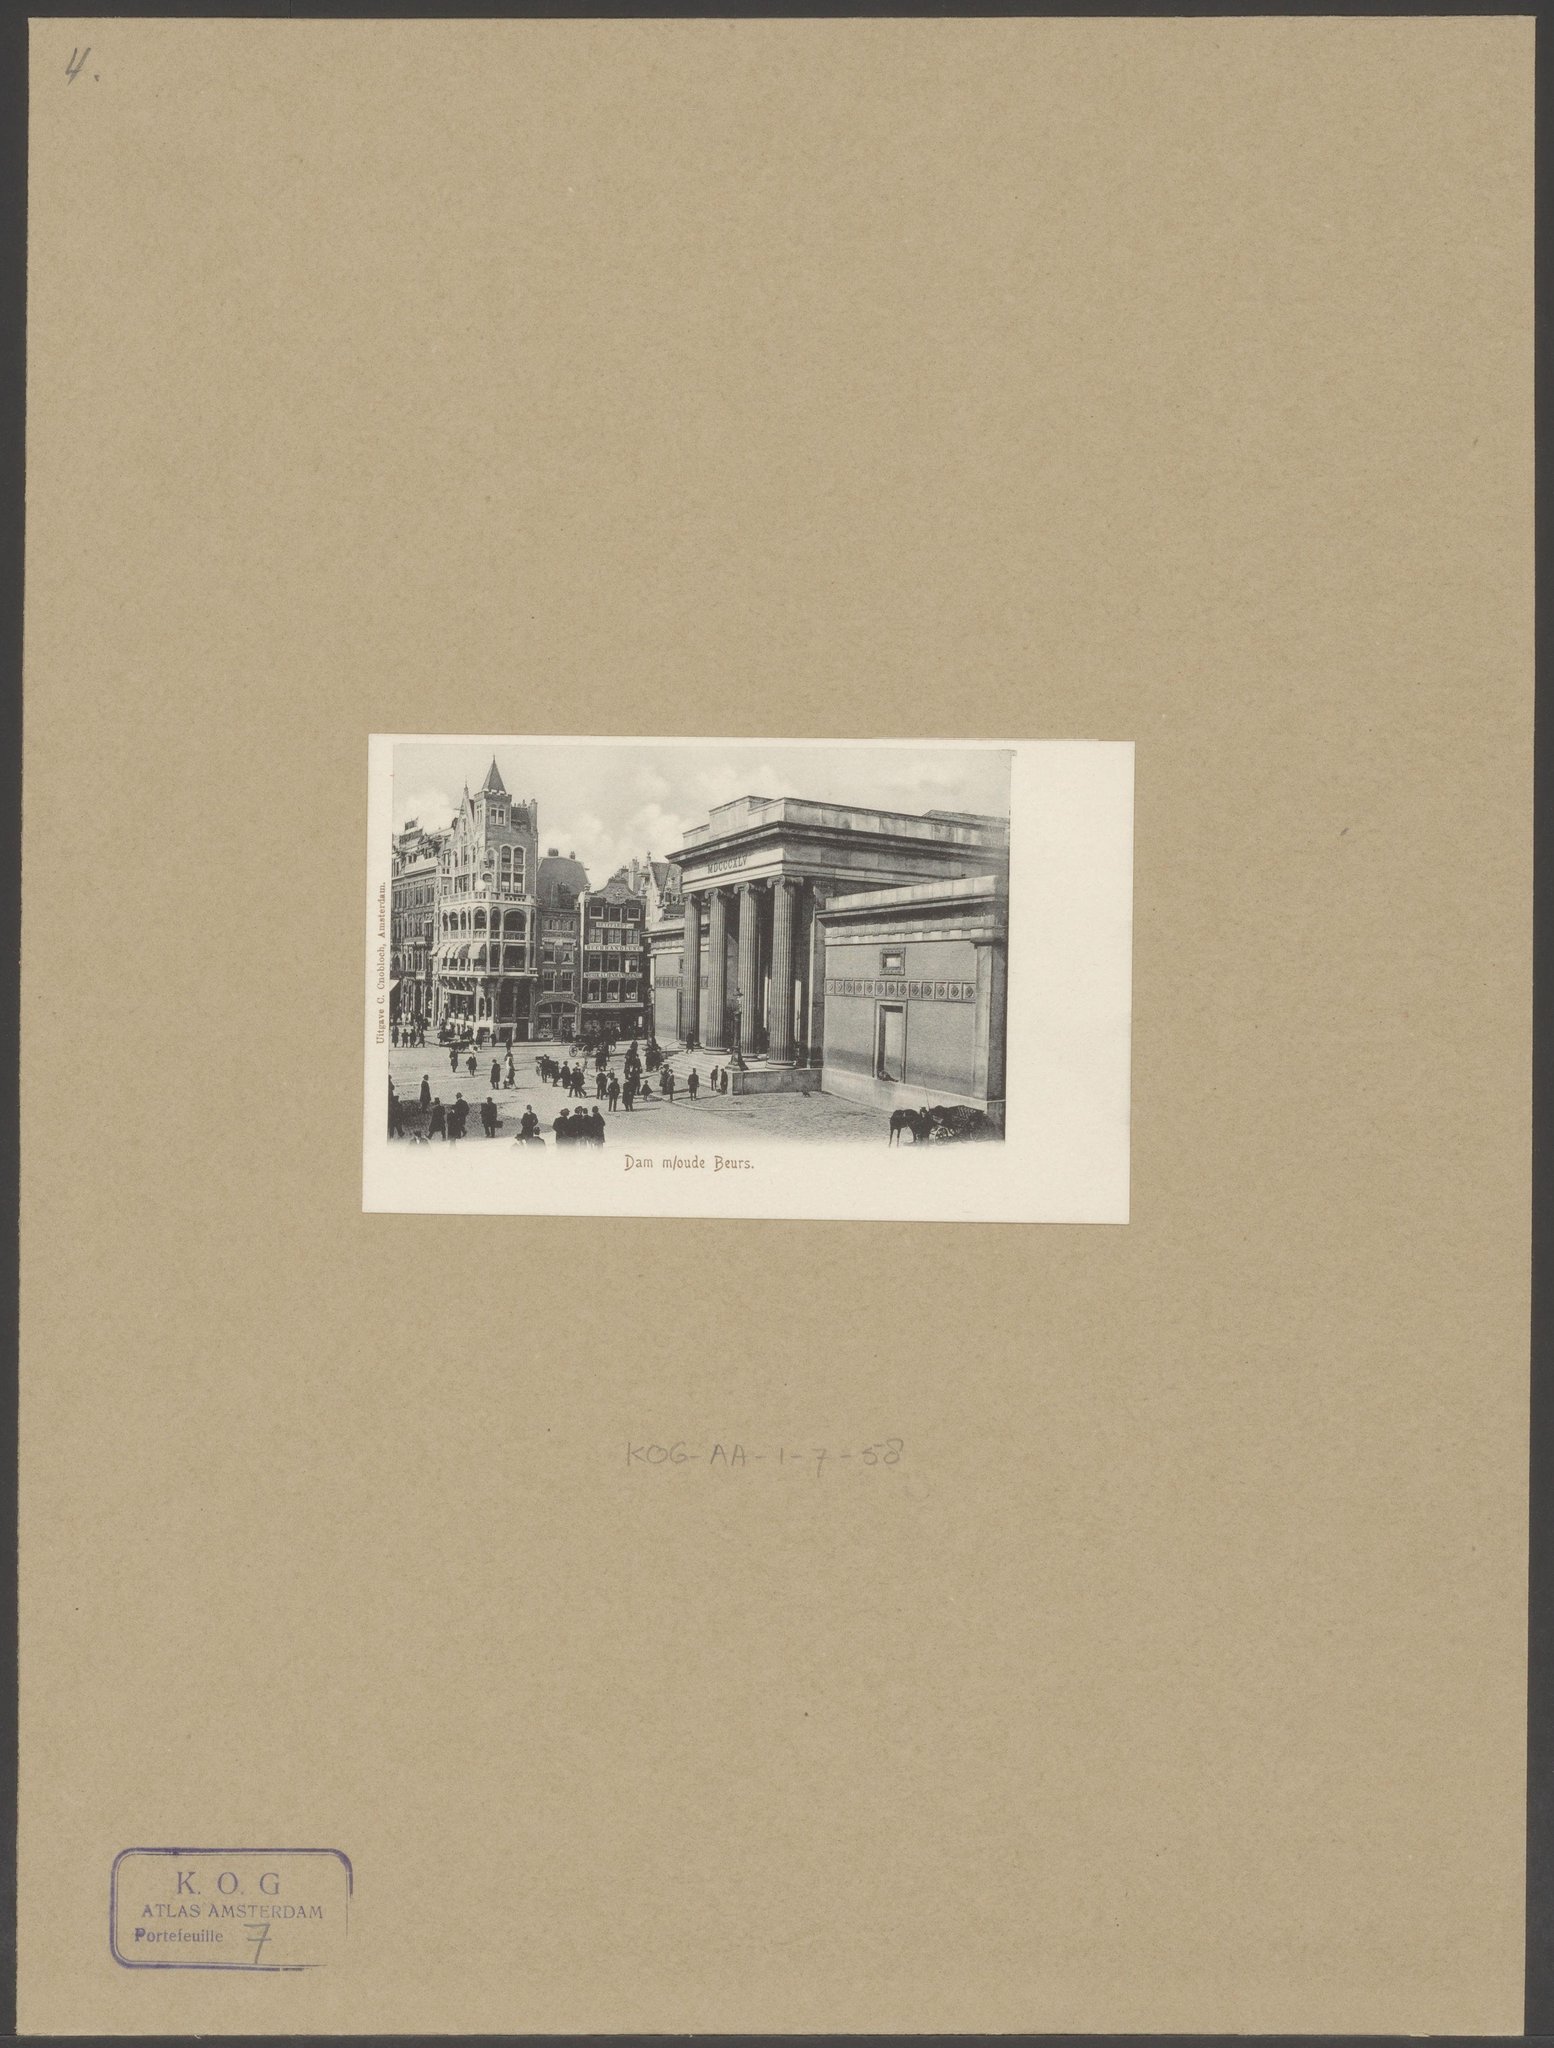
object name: photomechanical print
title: Gezicht op de Beurs van Zocher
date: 1875-1903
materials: paper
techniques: photograph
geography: amsterdam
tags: square, place, circus, etc., city-view in general; 'veduta', market-hall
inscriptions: collector's mark: ‘7’ Lugt 1641b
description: Onderwerpsrubriek binnen de Atlas Amsterdam: Dam (na 1835).